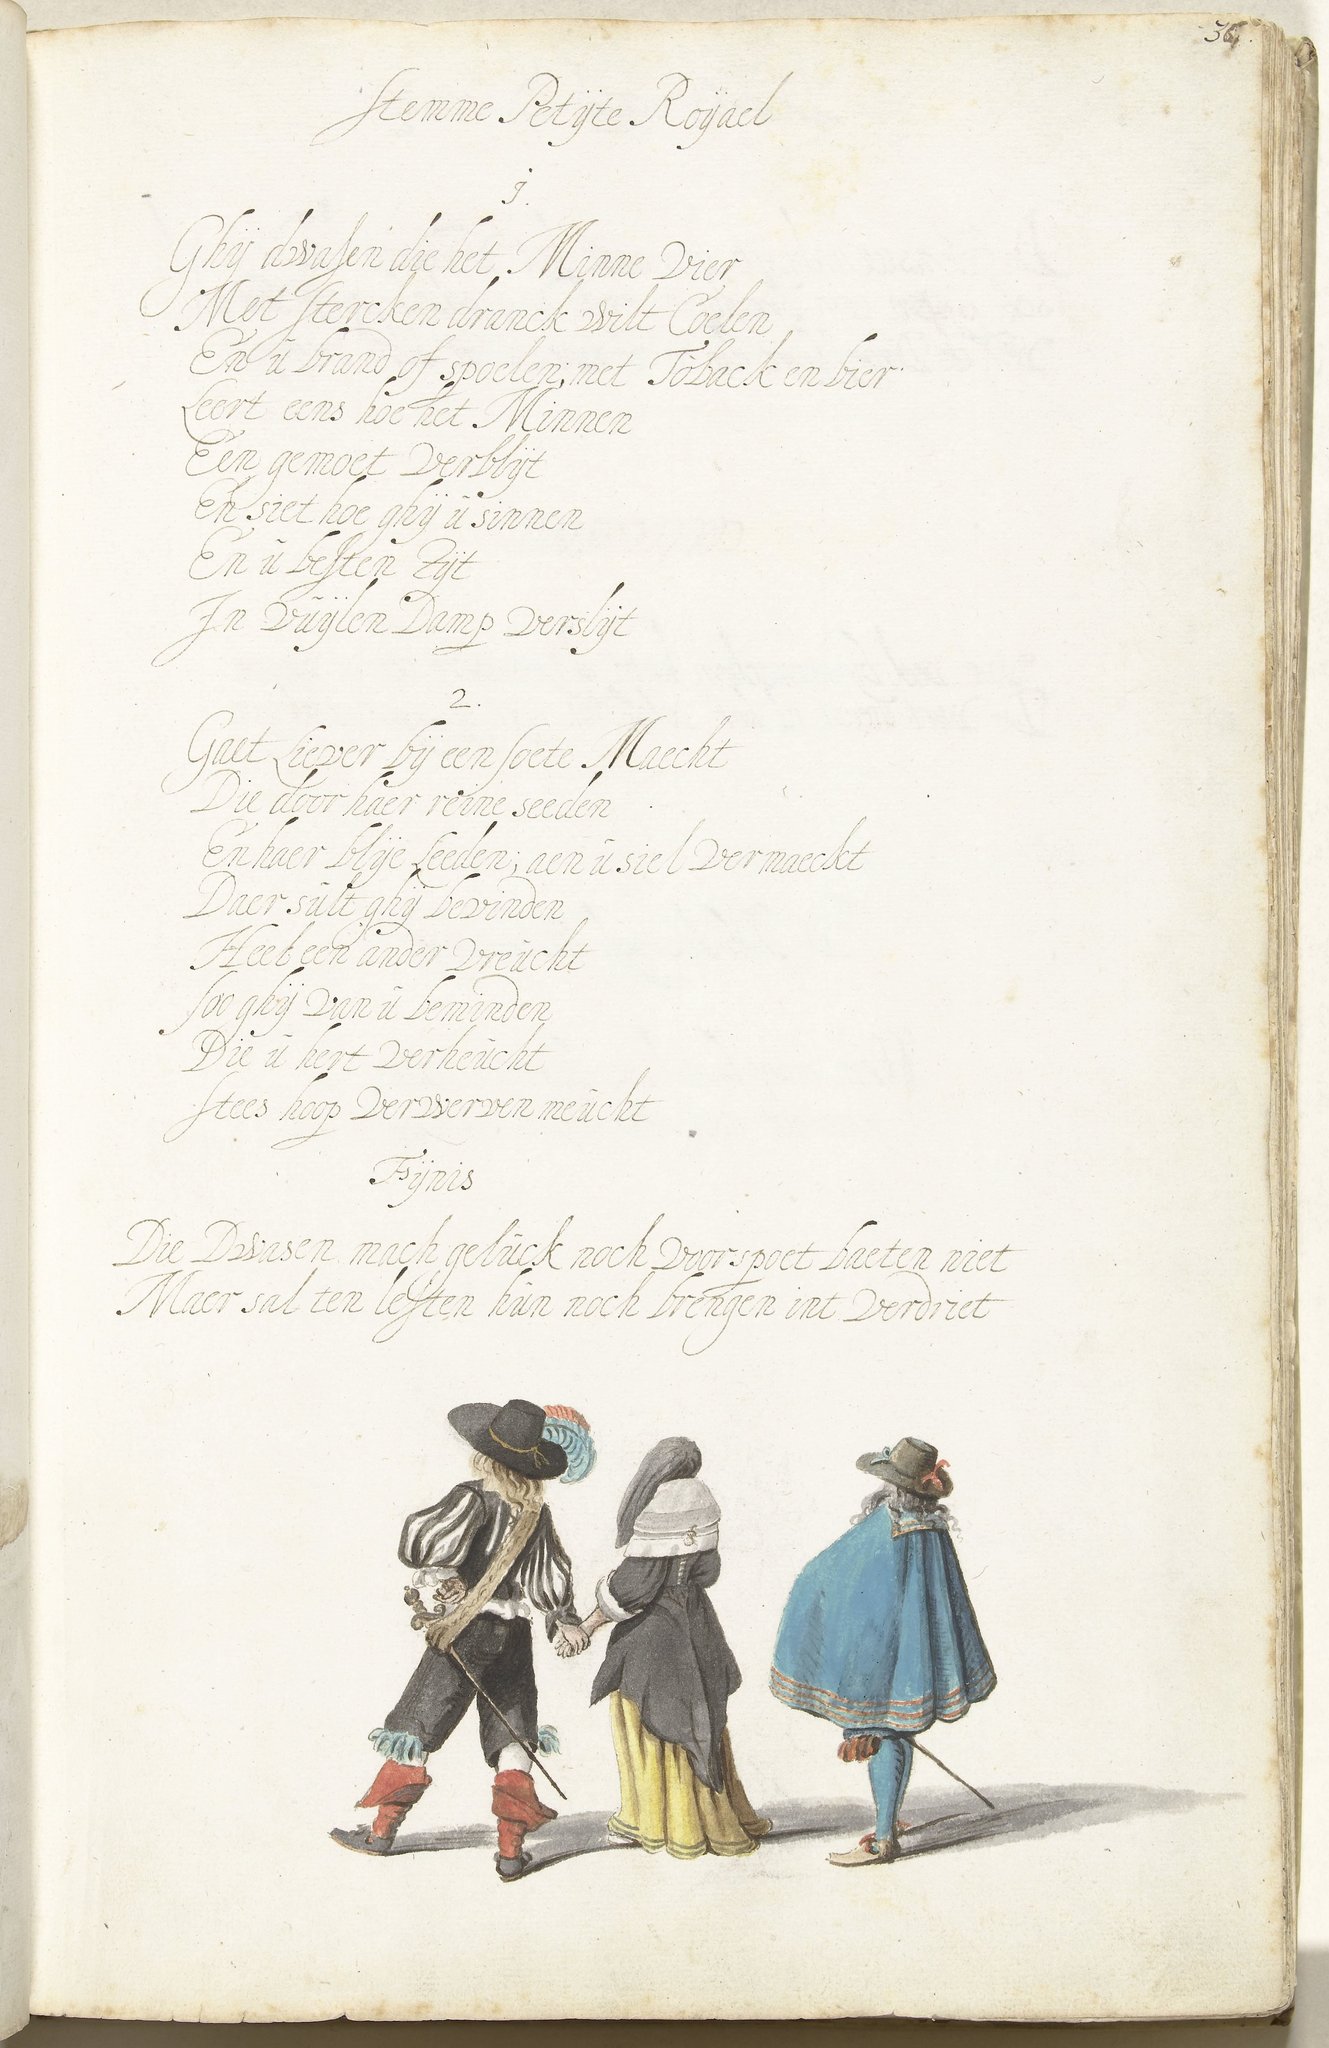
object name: drawing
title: Soldaat, dame en heer, van achteren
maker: gesina ter borch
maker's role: draughtsman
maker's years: 1633-1690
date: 1653-1654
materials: ink, paper, watercolor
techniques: brush, calligraphy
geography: zwolle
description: Soldaat, dame en een heer bij een moraliserend gedicht op de melodie van Petijte Roijael.